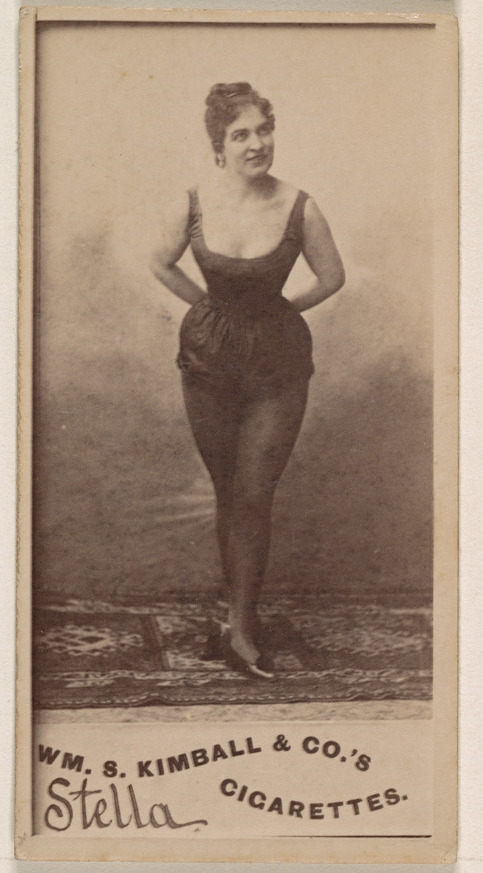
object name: photograph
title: Miss Stella, from the Actresses series (N203) issued by Wm. S. Kimball & Co.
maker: william s. kimball & company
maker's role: publisher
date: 1889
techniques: color lithograph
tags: portraits,women,actresses